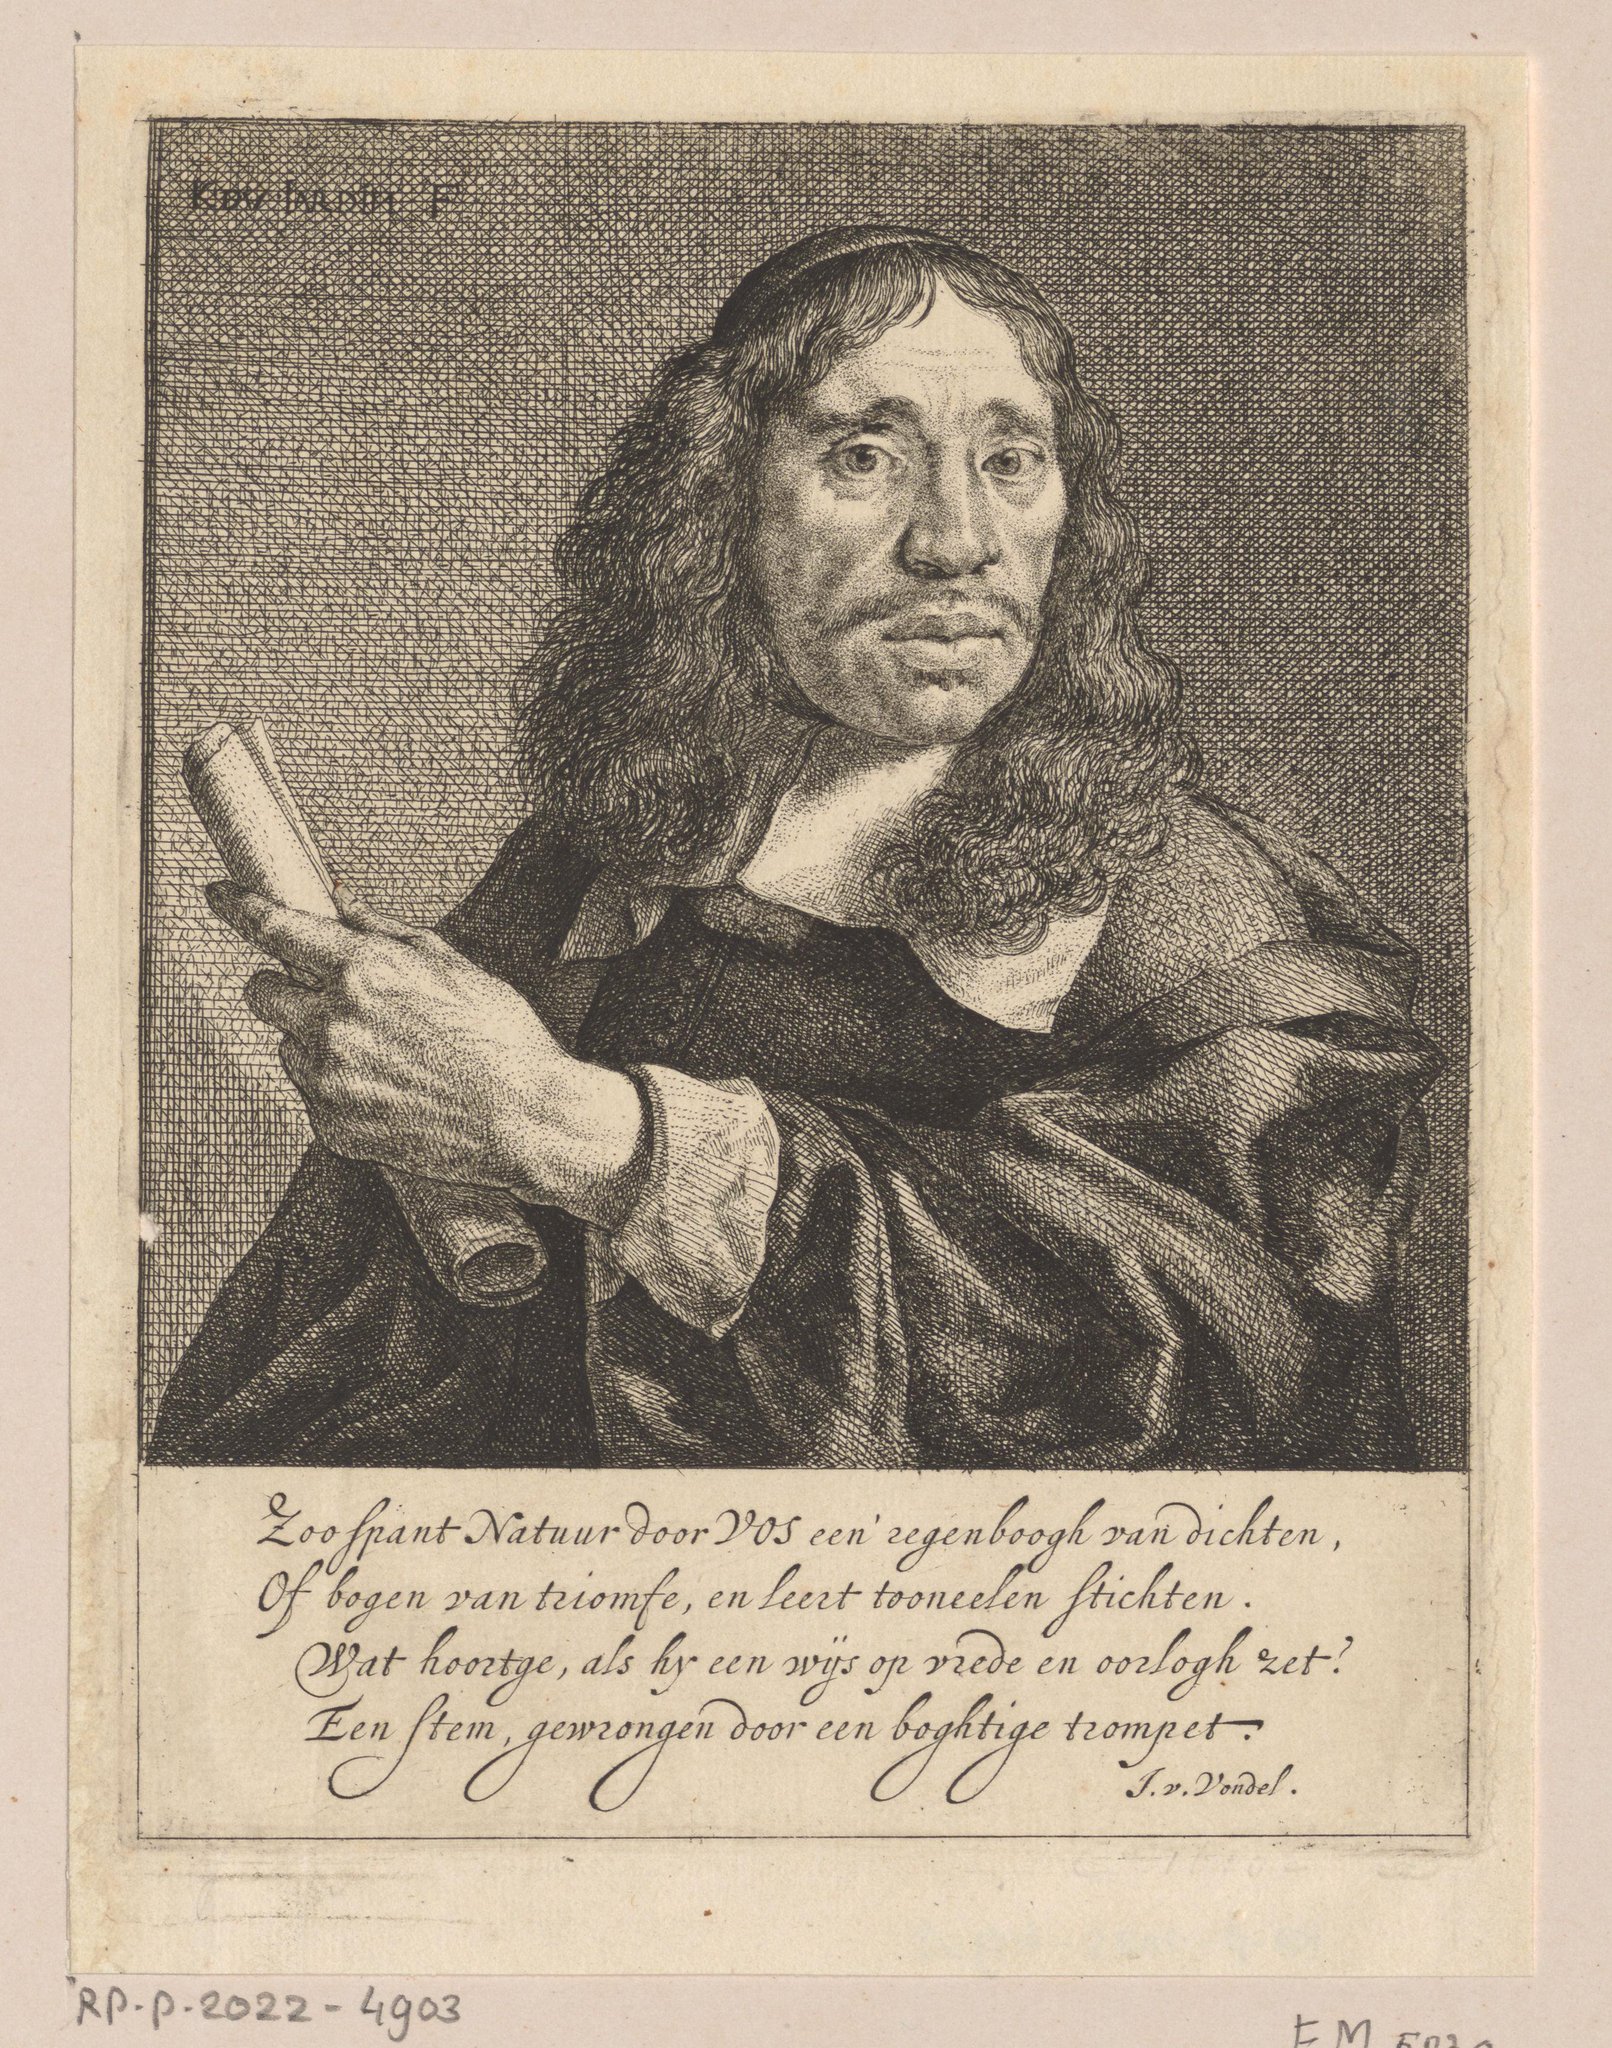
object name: print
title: Portret van Jan de Vos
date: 1662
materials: paper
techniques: etching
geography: northern netherlands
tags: amsterdam, jan vos, historical persons, portrait of a writer, writer, poet, author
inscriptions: collector's mark: Lugt 2228